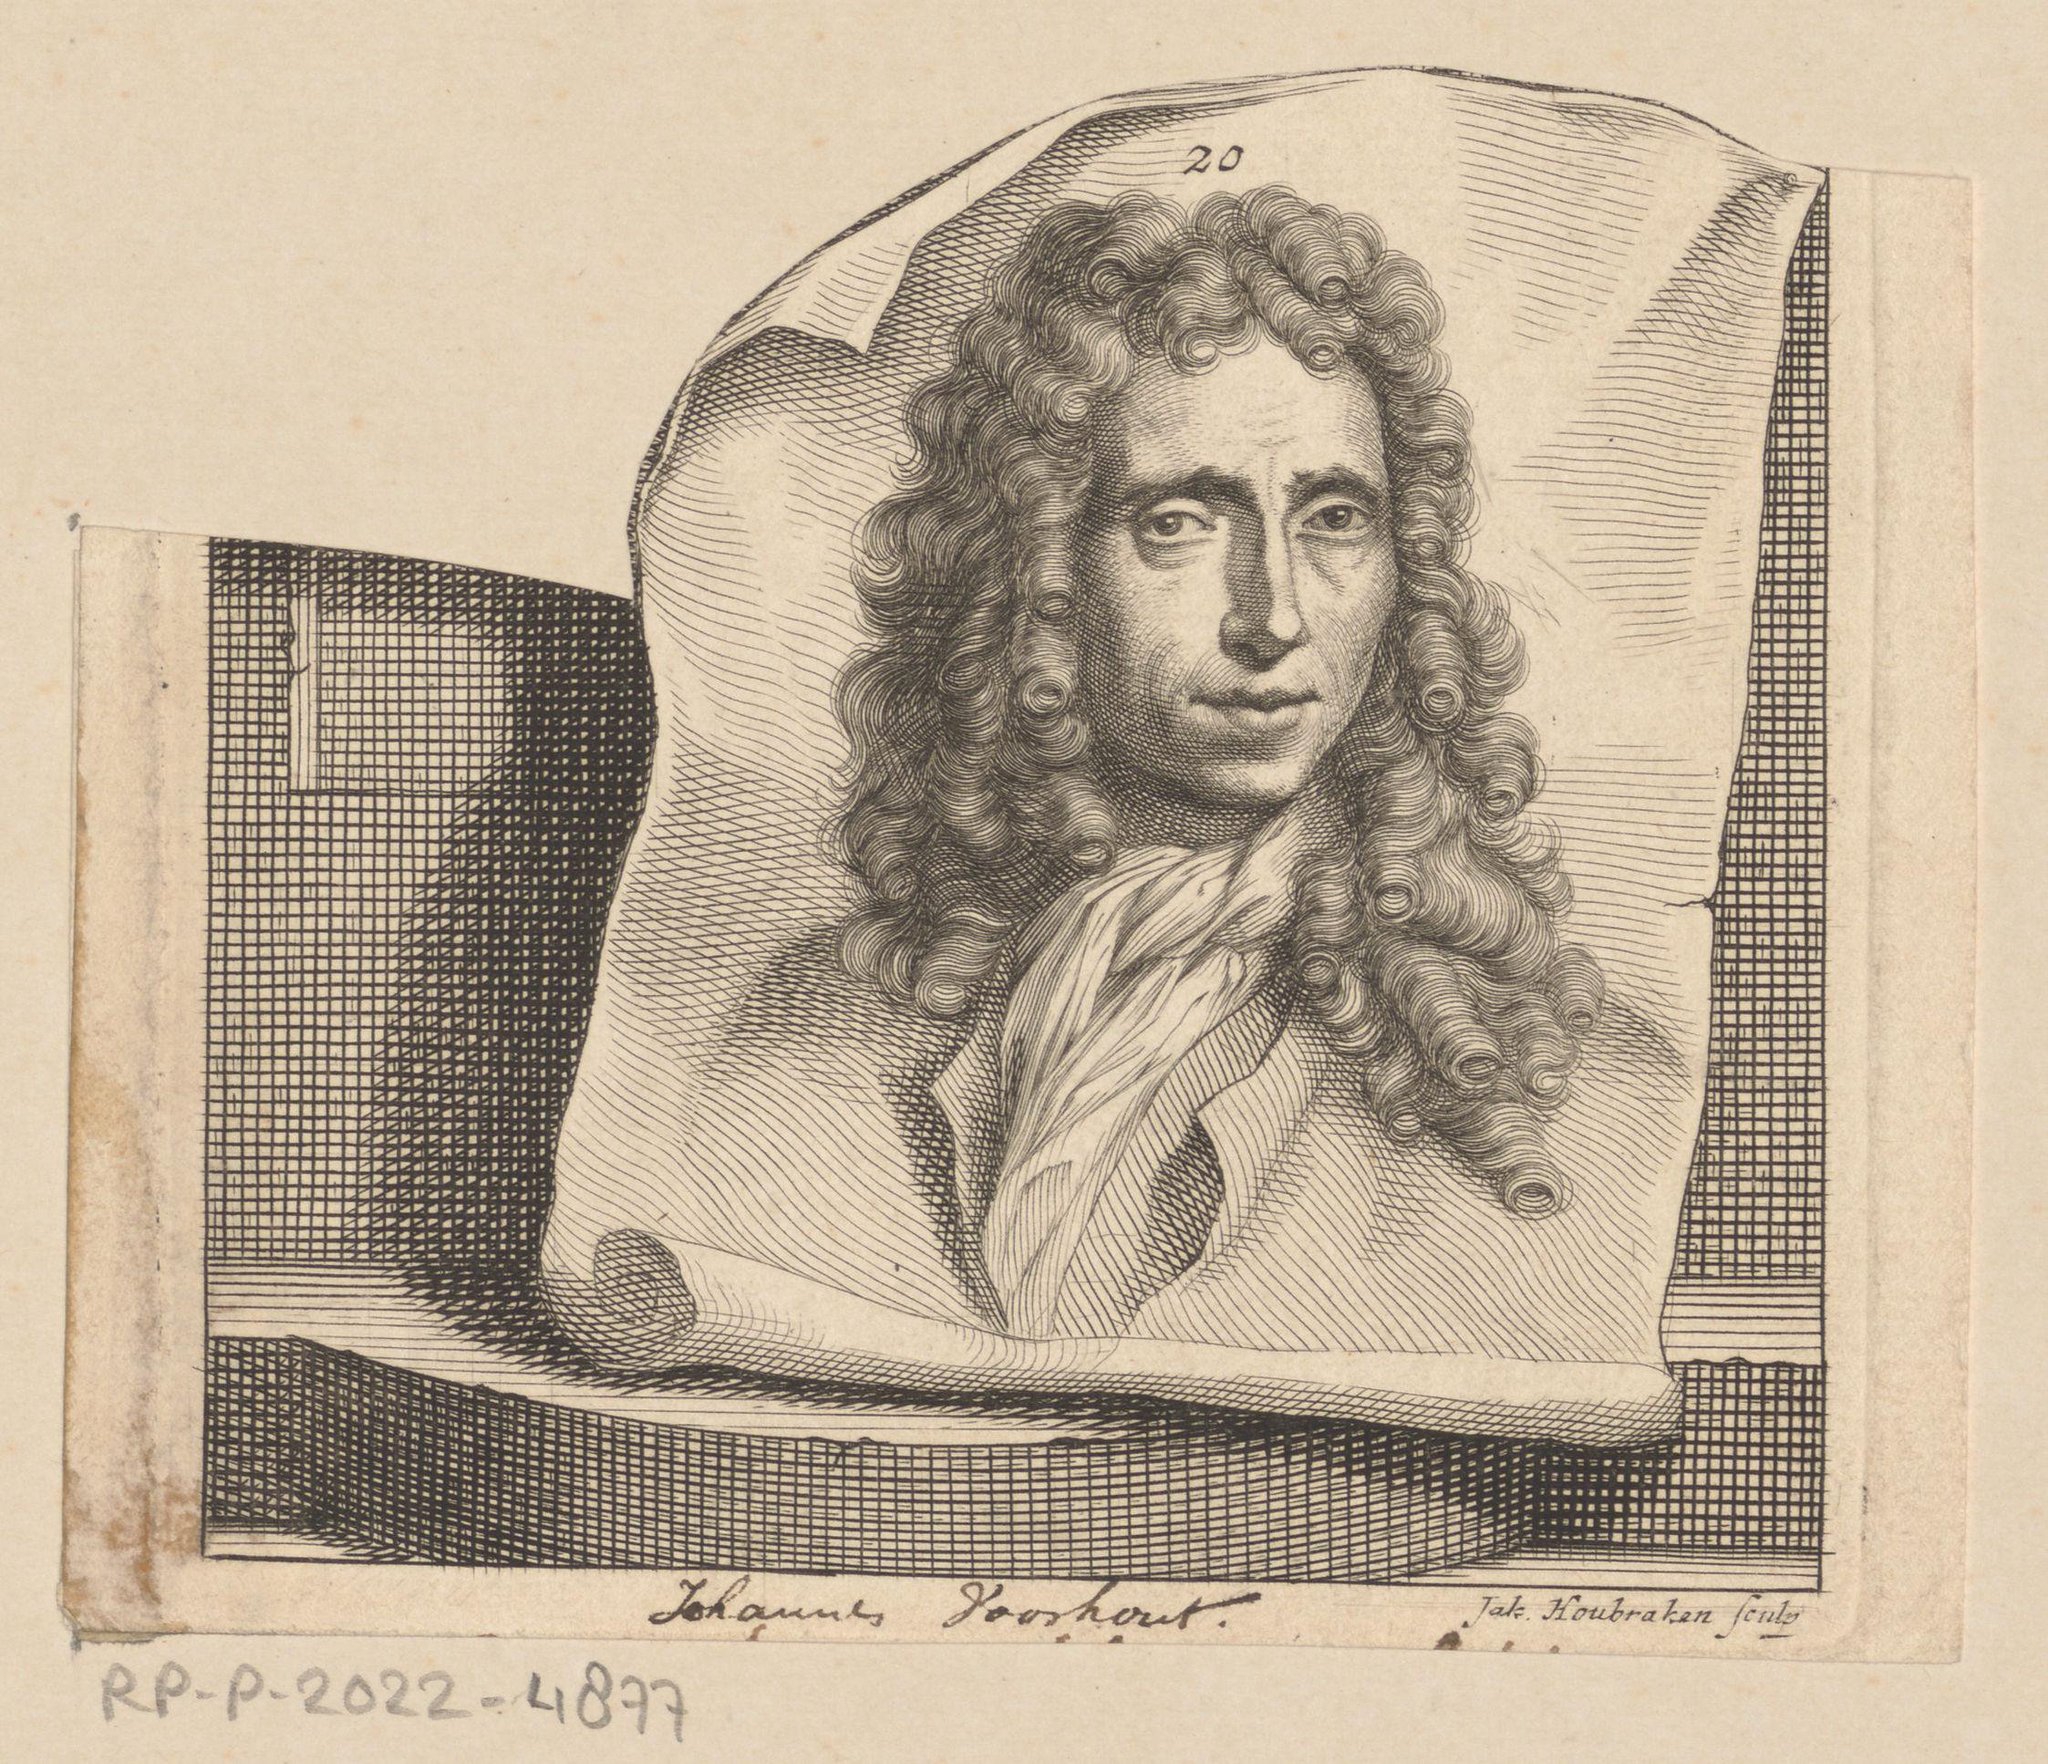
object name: print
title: Portret van Johannes Voorhout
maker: jacob houbraken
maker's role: draughtsman, print maker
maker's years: 1698-1780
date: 1721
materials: paper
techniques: engraving, etching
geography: amsterdam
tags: amsterdam, painter, draughtsman, johannes voorhout (i), historical persons, portrait, self-portrait of painter, portrait, self-portrait of draughtsman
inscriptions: collector's mark: Lugt 2228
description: Prent waarschijnlijk uit: Houbraken, Arnold. De groote schouburgh der Nederlantsche konstschilders en schilderessen (...). Amsterdam: Arnold Houbraken, 1721, dl. 3.